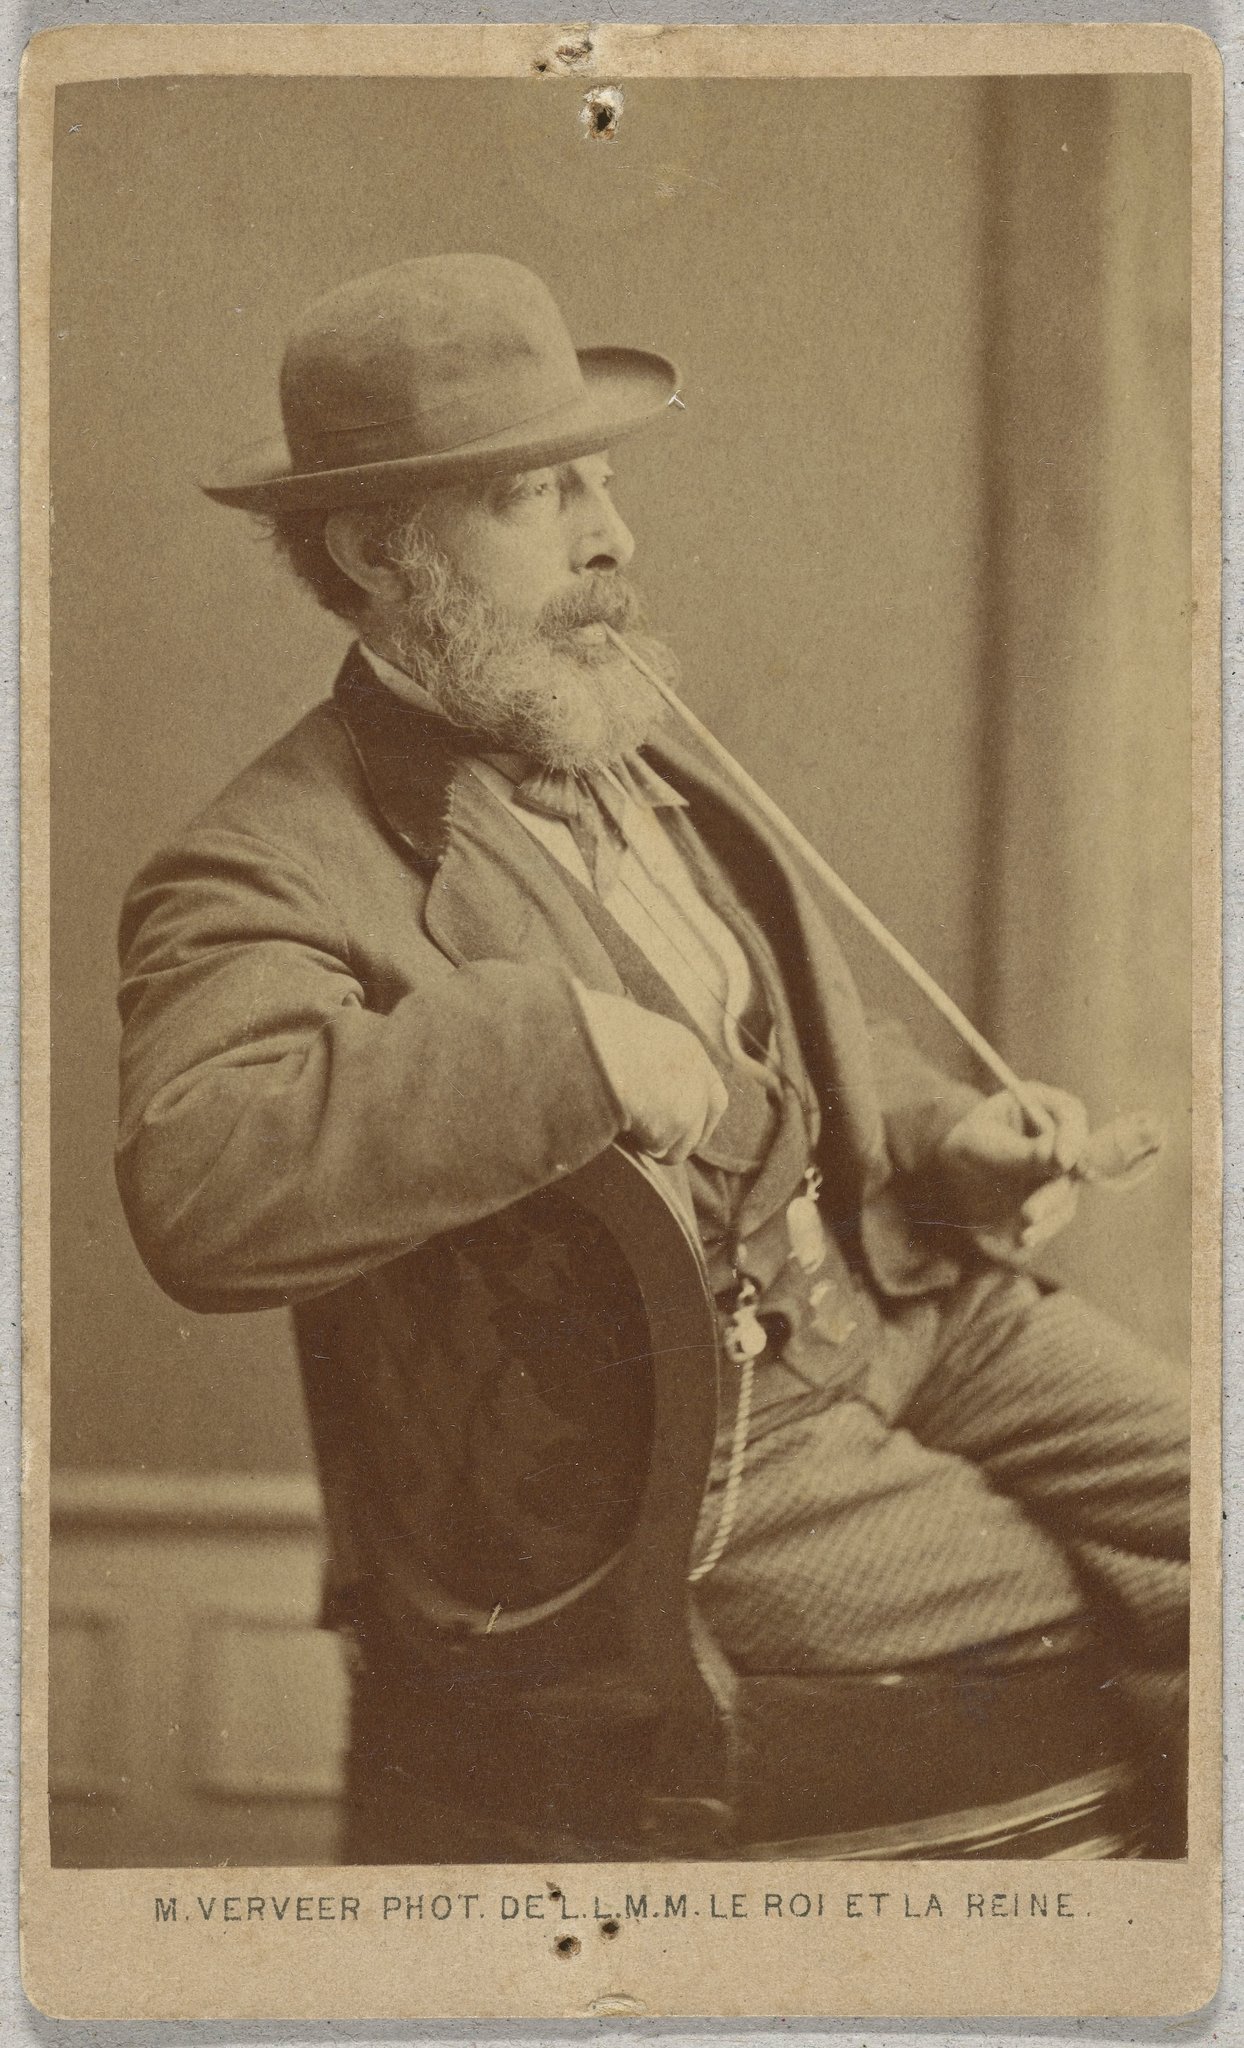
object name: carte de visite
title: Zelfportret van Maurits Verveer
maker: maurits verveer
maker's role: painter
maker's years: 1817-1903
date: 1850-1875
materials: cardboard, paper, photographic support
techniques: albumen print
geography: the hague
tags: the hague, painter, maurits verveer, historical persons, portrait, self-portrait of artist, portrait, self-portrait of photographer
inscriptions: name: ‘M. Verveer phot. de L.L.M.M. le roi et la reine des Pays-Bas 52 Zeestraat vis a vis du Willemspark 52 La Haye’, annotation: ‘Les Cliches etant conserves indenifiment on peut toujours de procurer de nouvelle epreuves de Cartes & portraits’